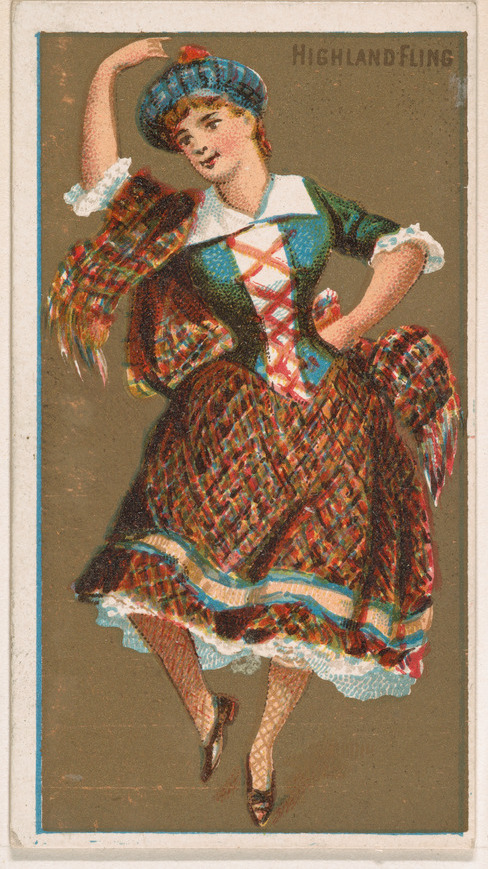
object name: print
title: Highland Fling, from National Dances (N225, Type 1) issued by Kinney Bros.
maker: kinney brothers tobacco company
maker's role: publisher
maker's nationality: american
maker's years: 1869-2011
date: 1889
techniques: color lithograph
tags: women,dancing,dancers